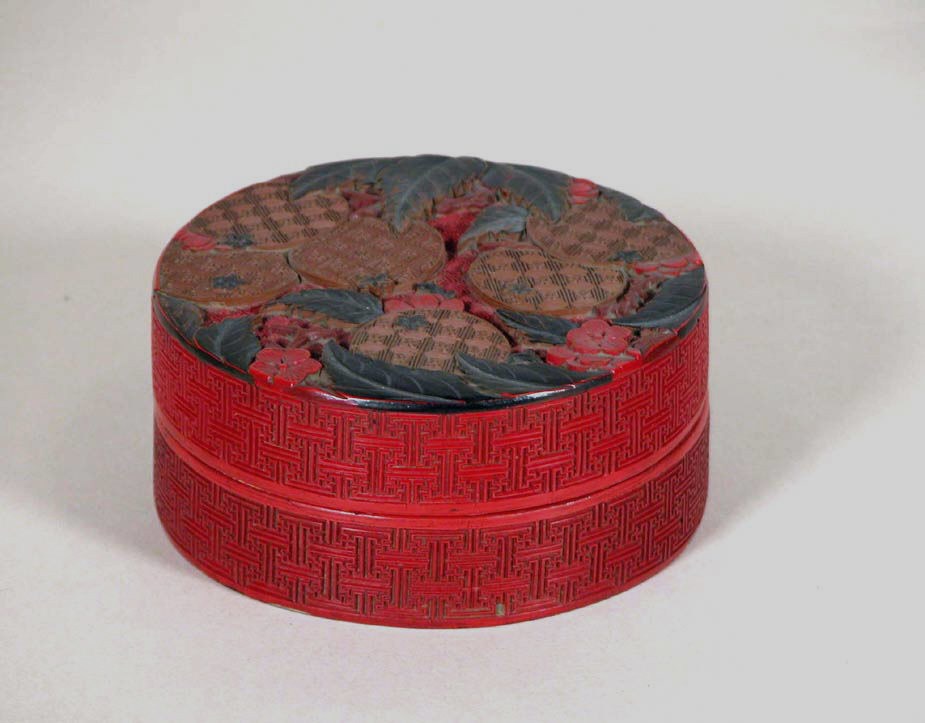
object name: incense box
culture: chinese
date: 1736-1795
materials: lacquer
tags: flowers